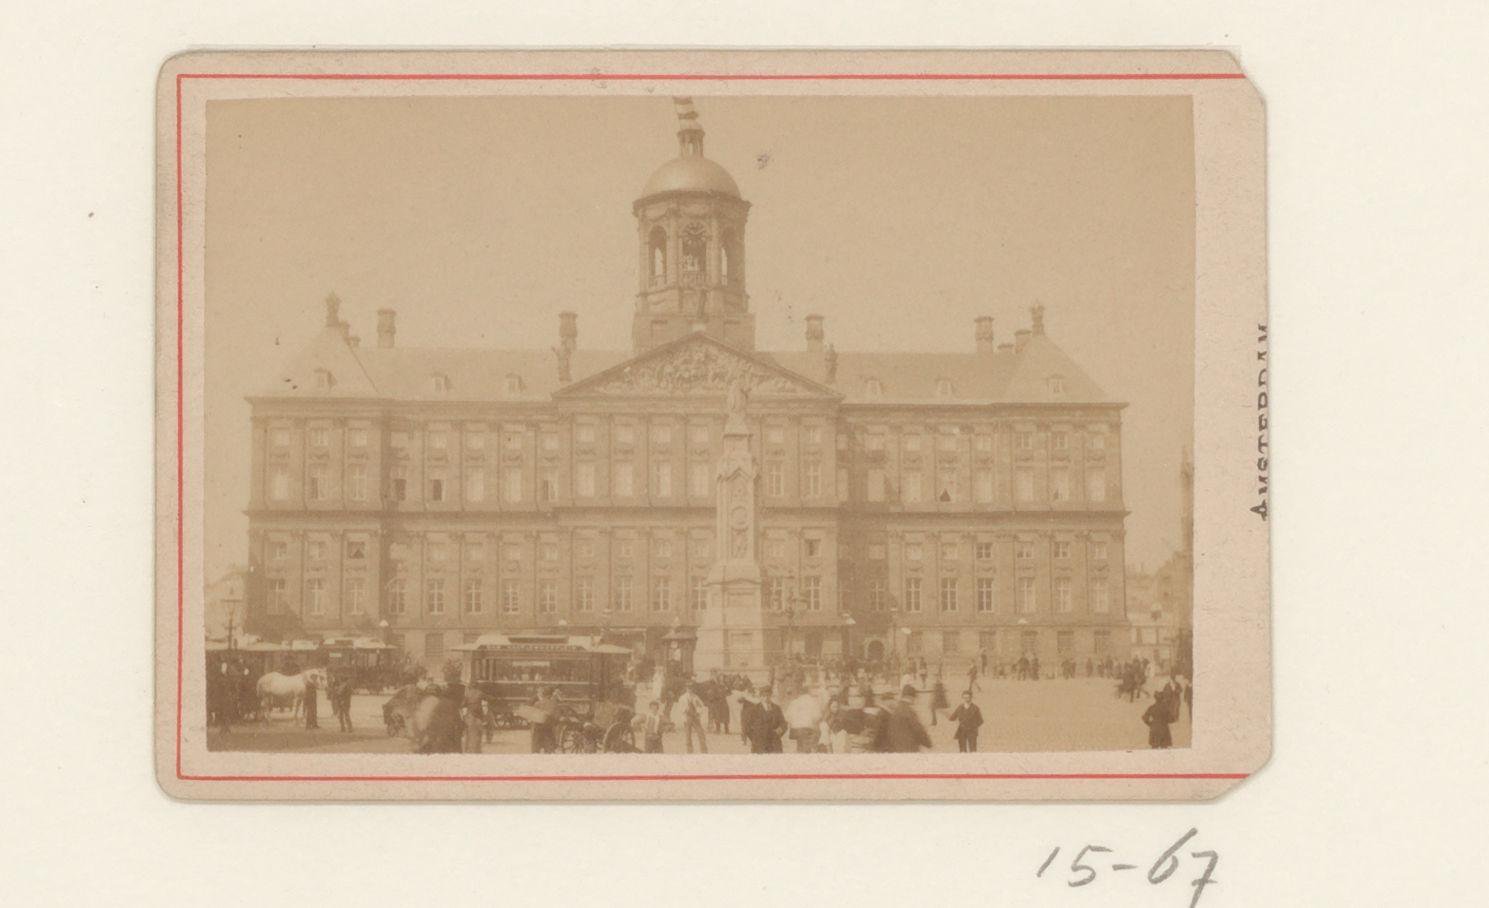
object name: carte de visite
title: Gezicht op het Paleis op de Dam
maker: Anonymous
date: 1850-1915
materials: cardboard, paper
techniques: albumen print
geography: amsterdam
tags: square, place, circus, etc., city-view in general; 'veduta', palace, royal palace of amsterdam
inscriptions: collector's mark: ‘15,67’ Lugt 1641b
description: Onderwerpsrubriek binnen de Atlas Amsterdam: Nieuwe Stadhuis, als Paleis, op de Dam, van Buiten.